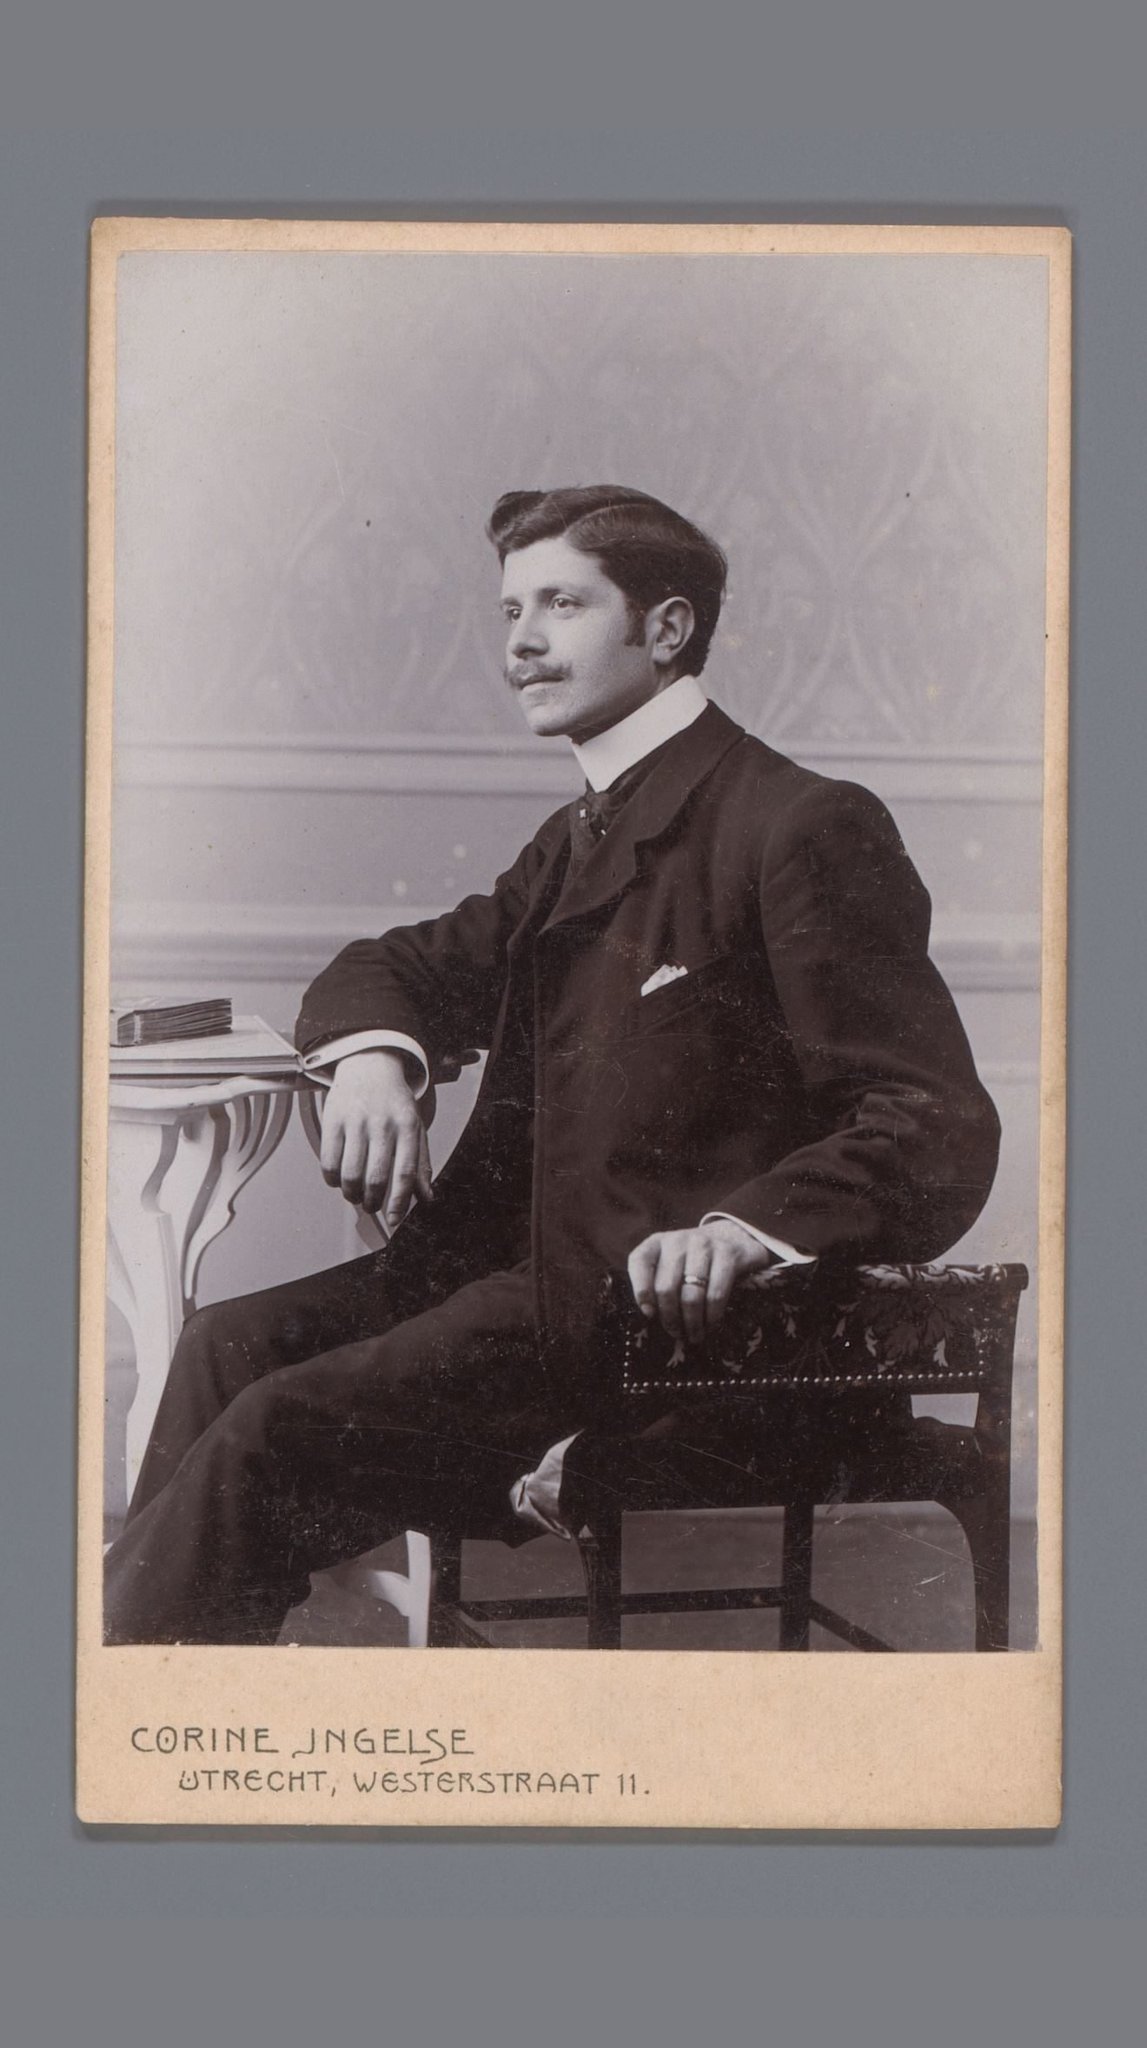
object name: carte de visite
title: Portret van een onbekende man, zittend aan tafel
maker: corinne ingelsen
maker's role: fotograaf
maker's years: 1869-1950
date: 1898-1912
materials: cardboard, photographic support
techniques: collodion silver print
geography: utrecht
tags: sitting figure, adult man, historical persons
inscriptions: inscription: ‘CORINE/ INGELSE/ UTRECHT/ Westerstraat 11./ De negatieven blijven/ voor nabestelling/ bewaard./ L.G.K. & S. FST.’